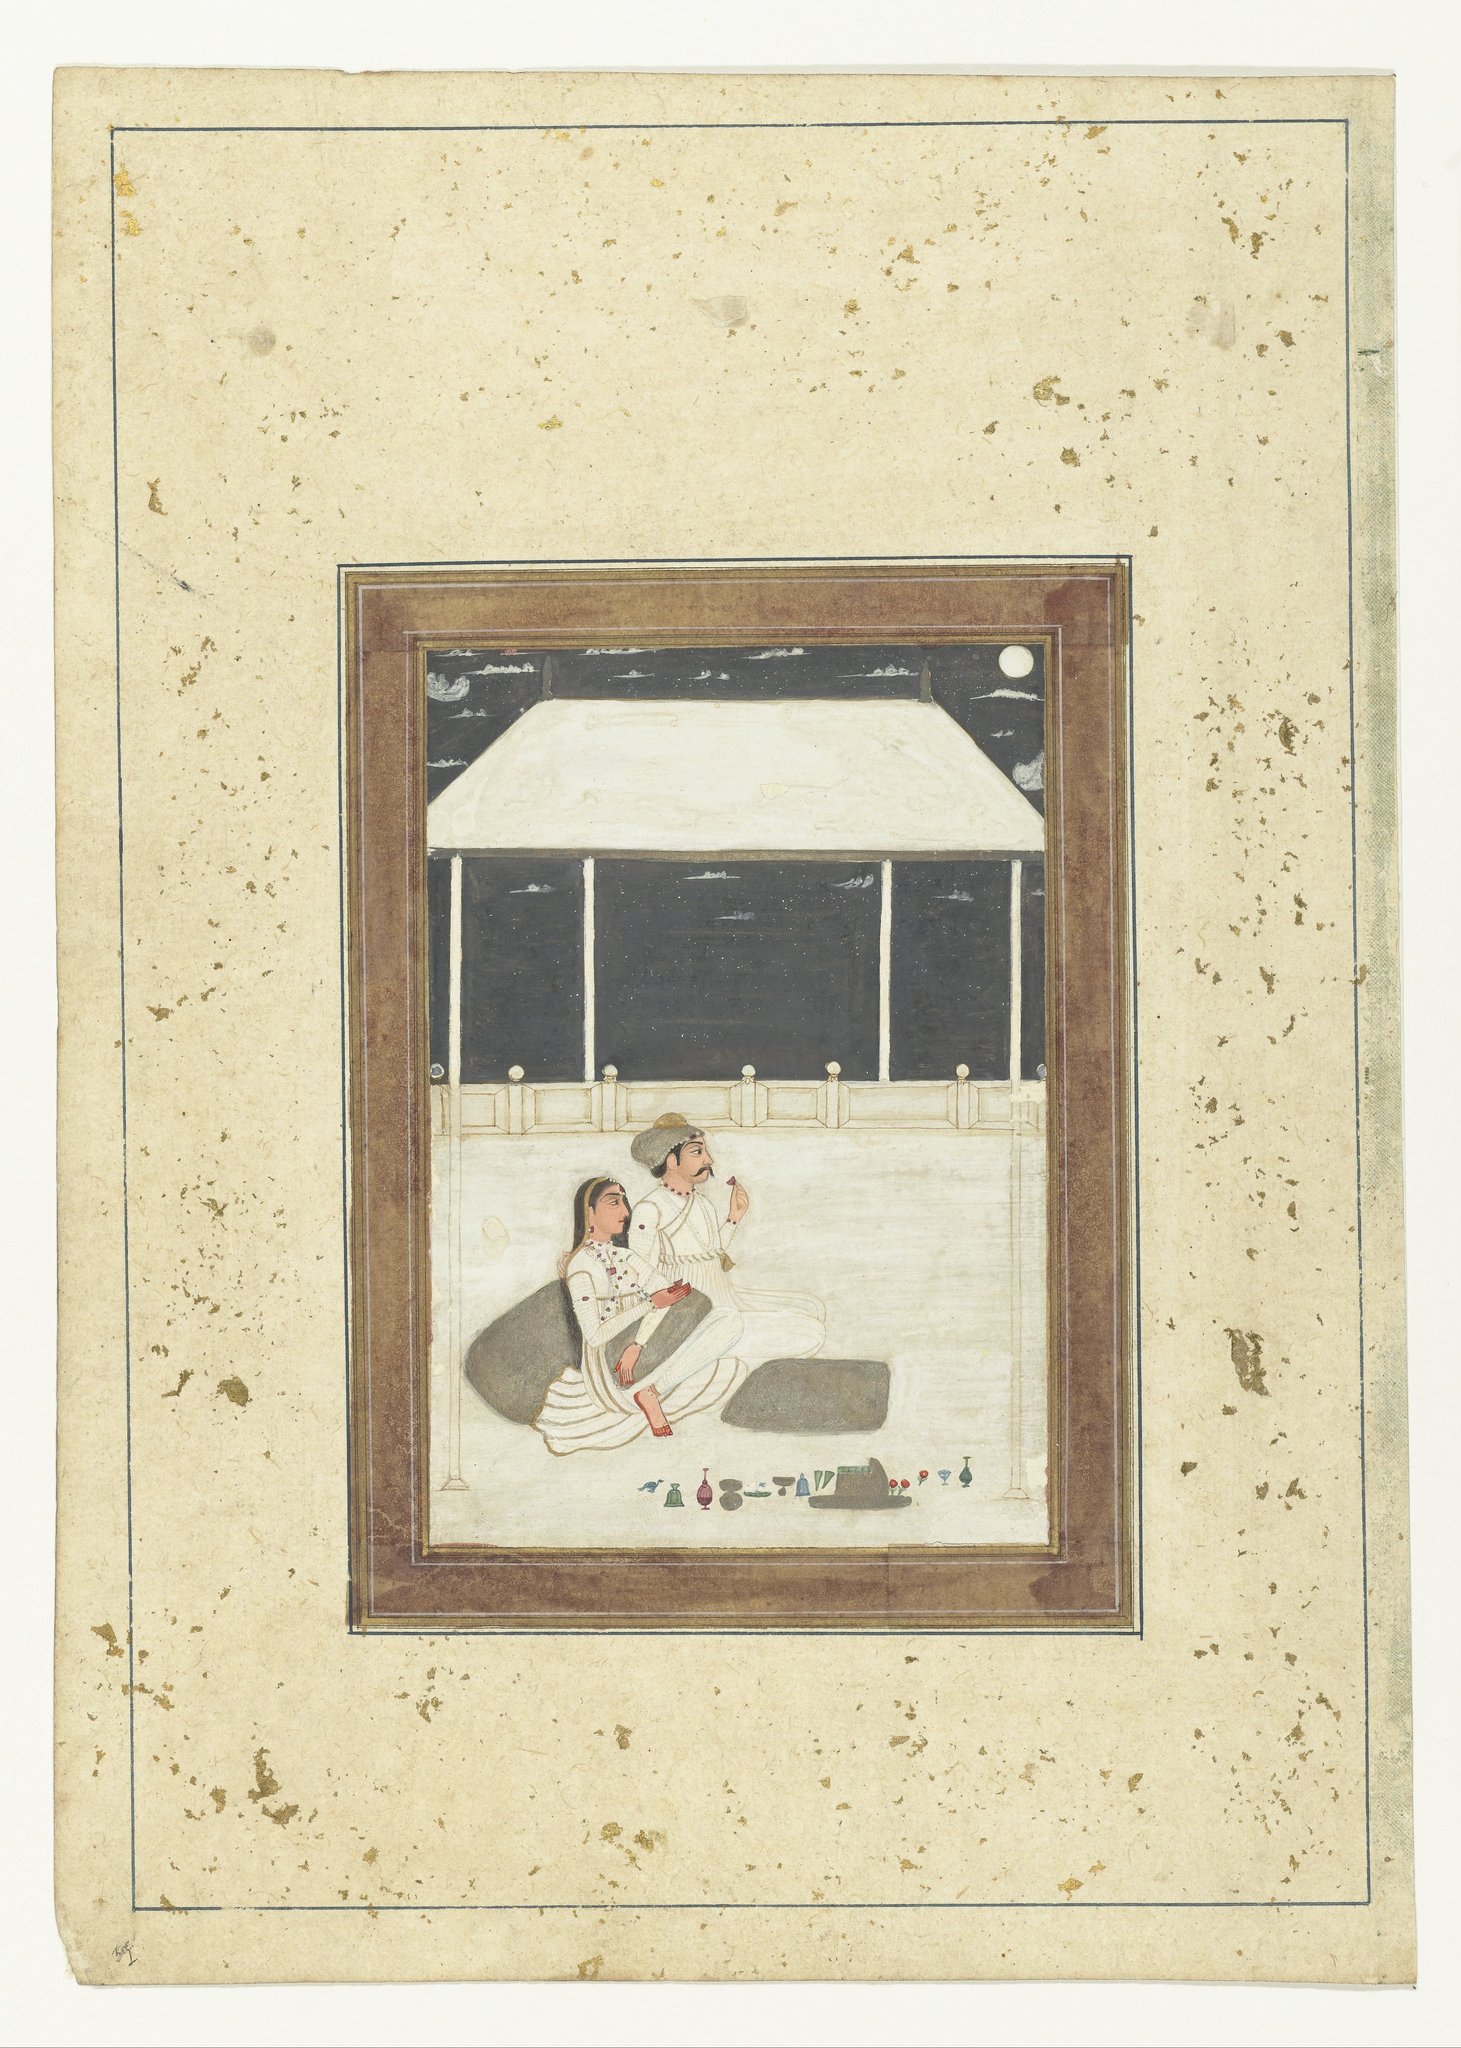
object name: drawing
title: Zittend paar op een terras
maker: Anonymous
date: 1770-1790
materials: paper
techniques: brush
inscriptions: inscription: ‘.’